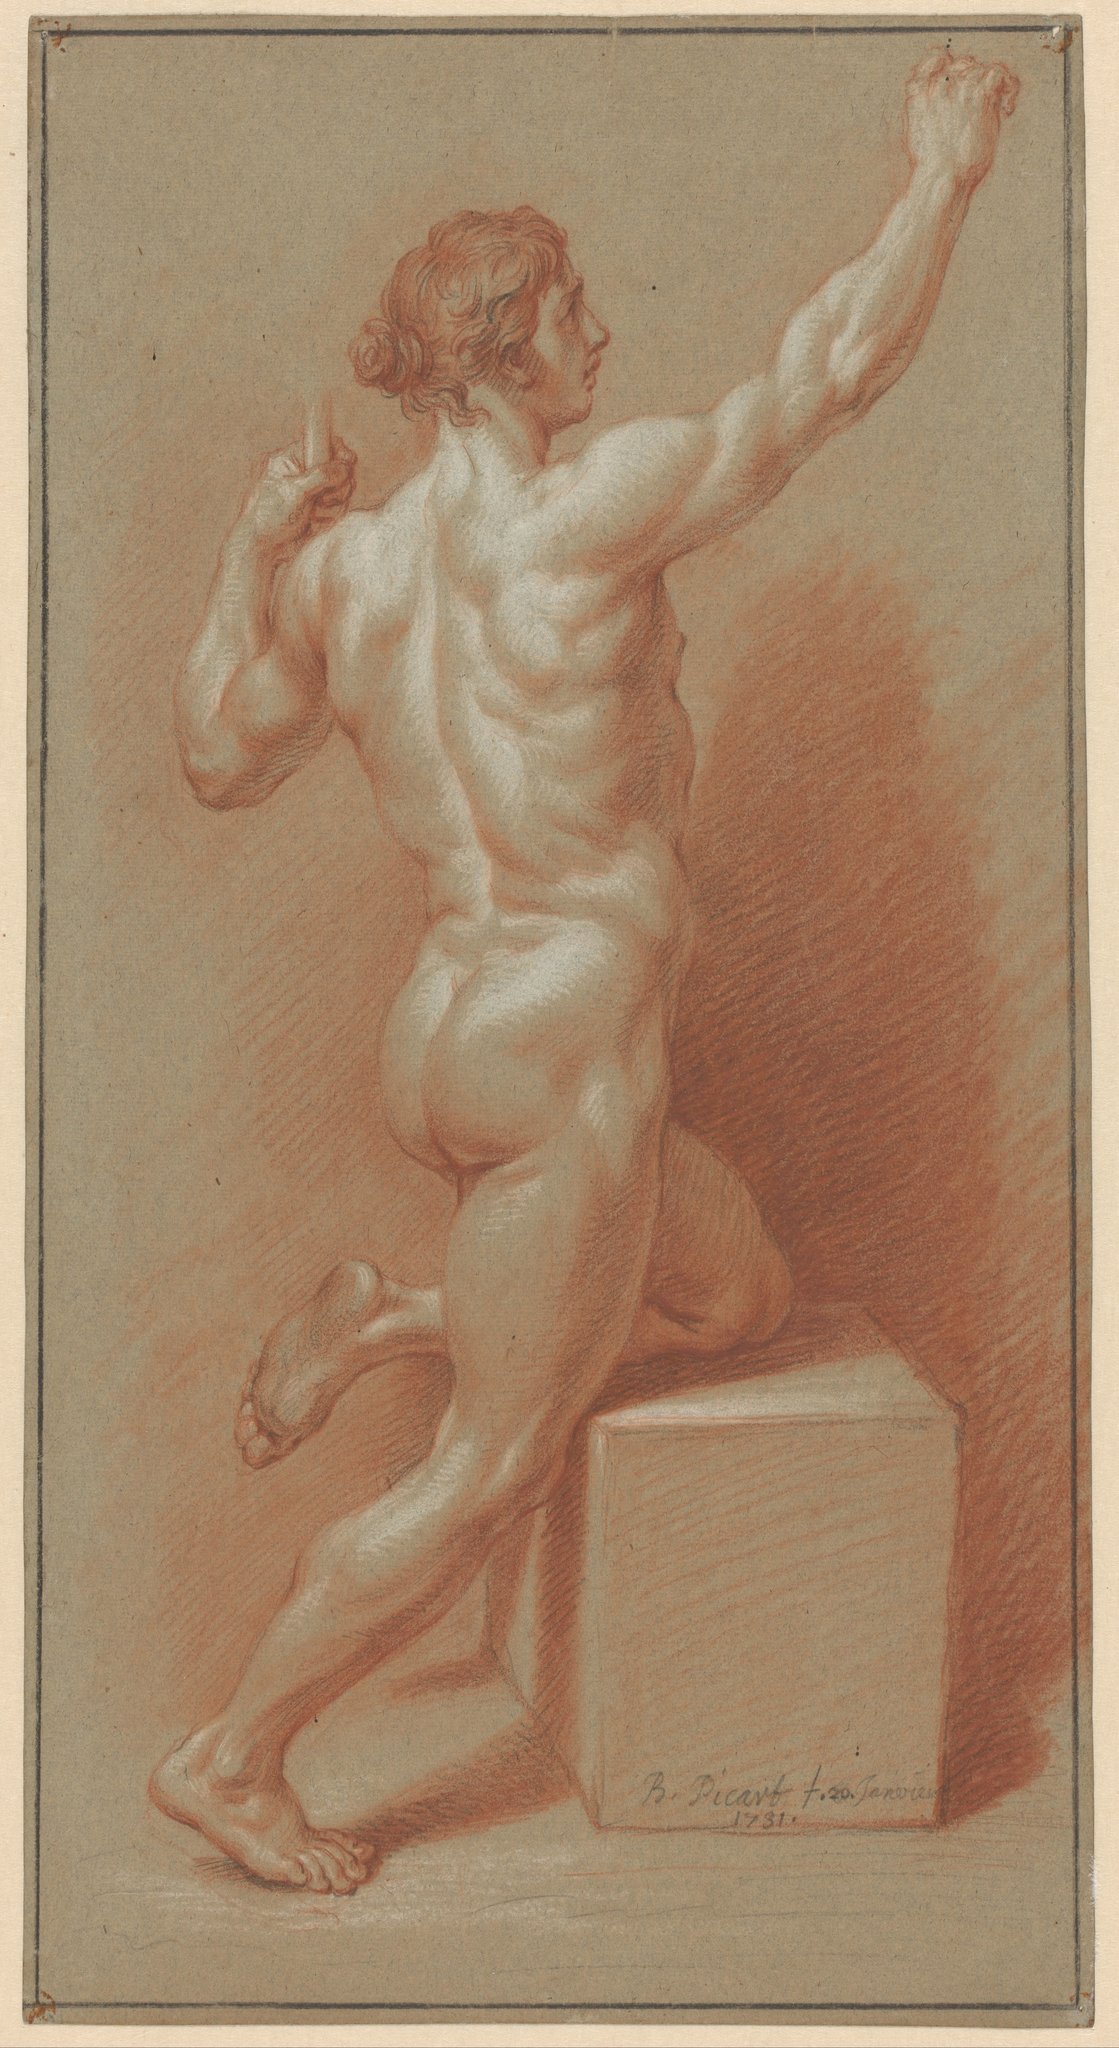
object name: drawing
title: Naakte man steunend op de linkerknie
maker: bernard picart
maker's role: draughtsman, print maker, publisher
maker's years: 1673-1733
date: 1731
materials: chalk, paper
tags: the (nude) human figure; 'corpo humano' (ripa)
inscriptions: date